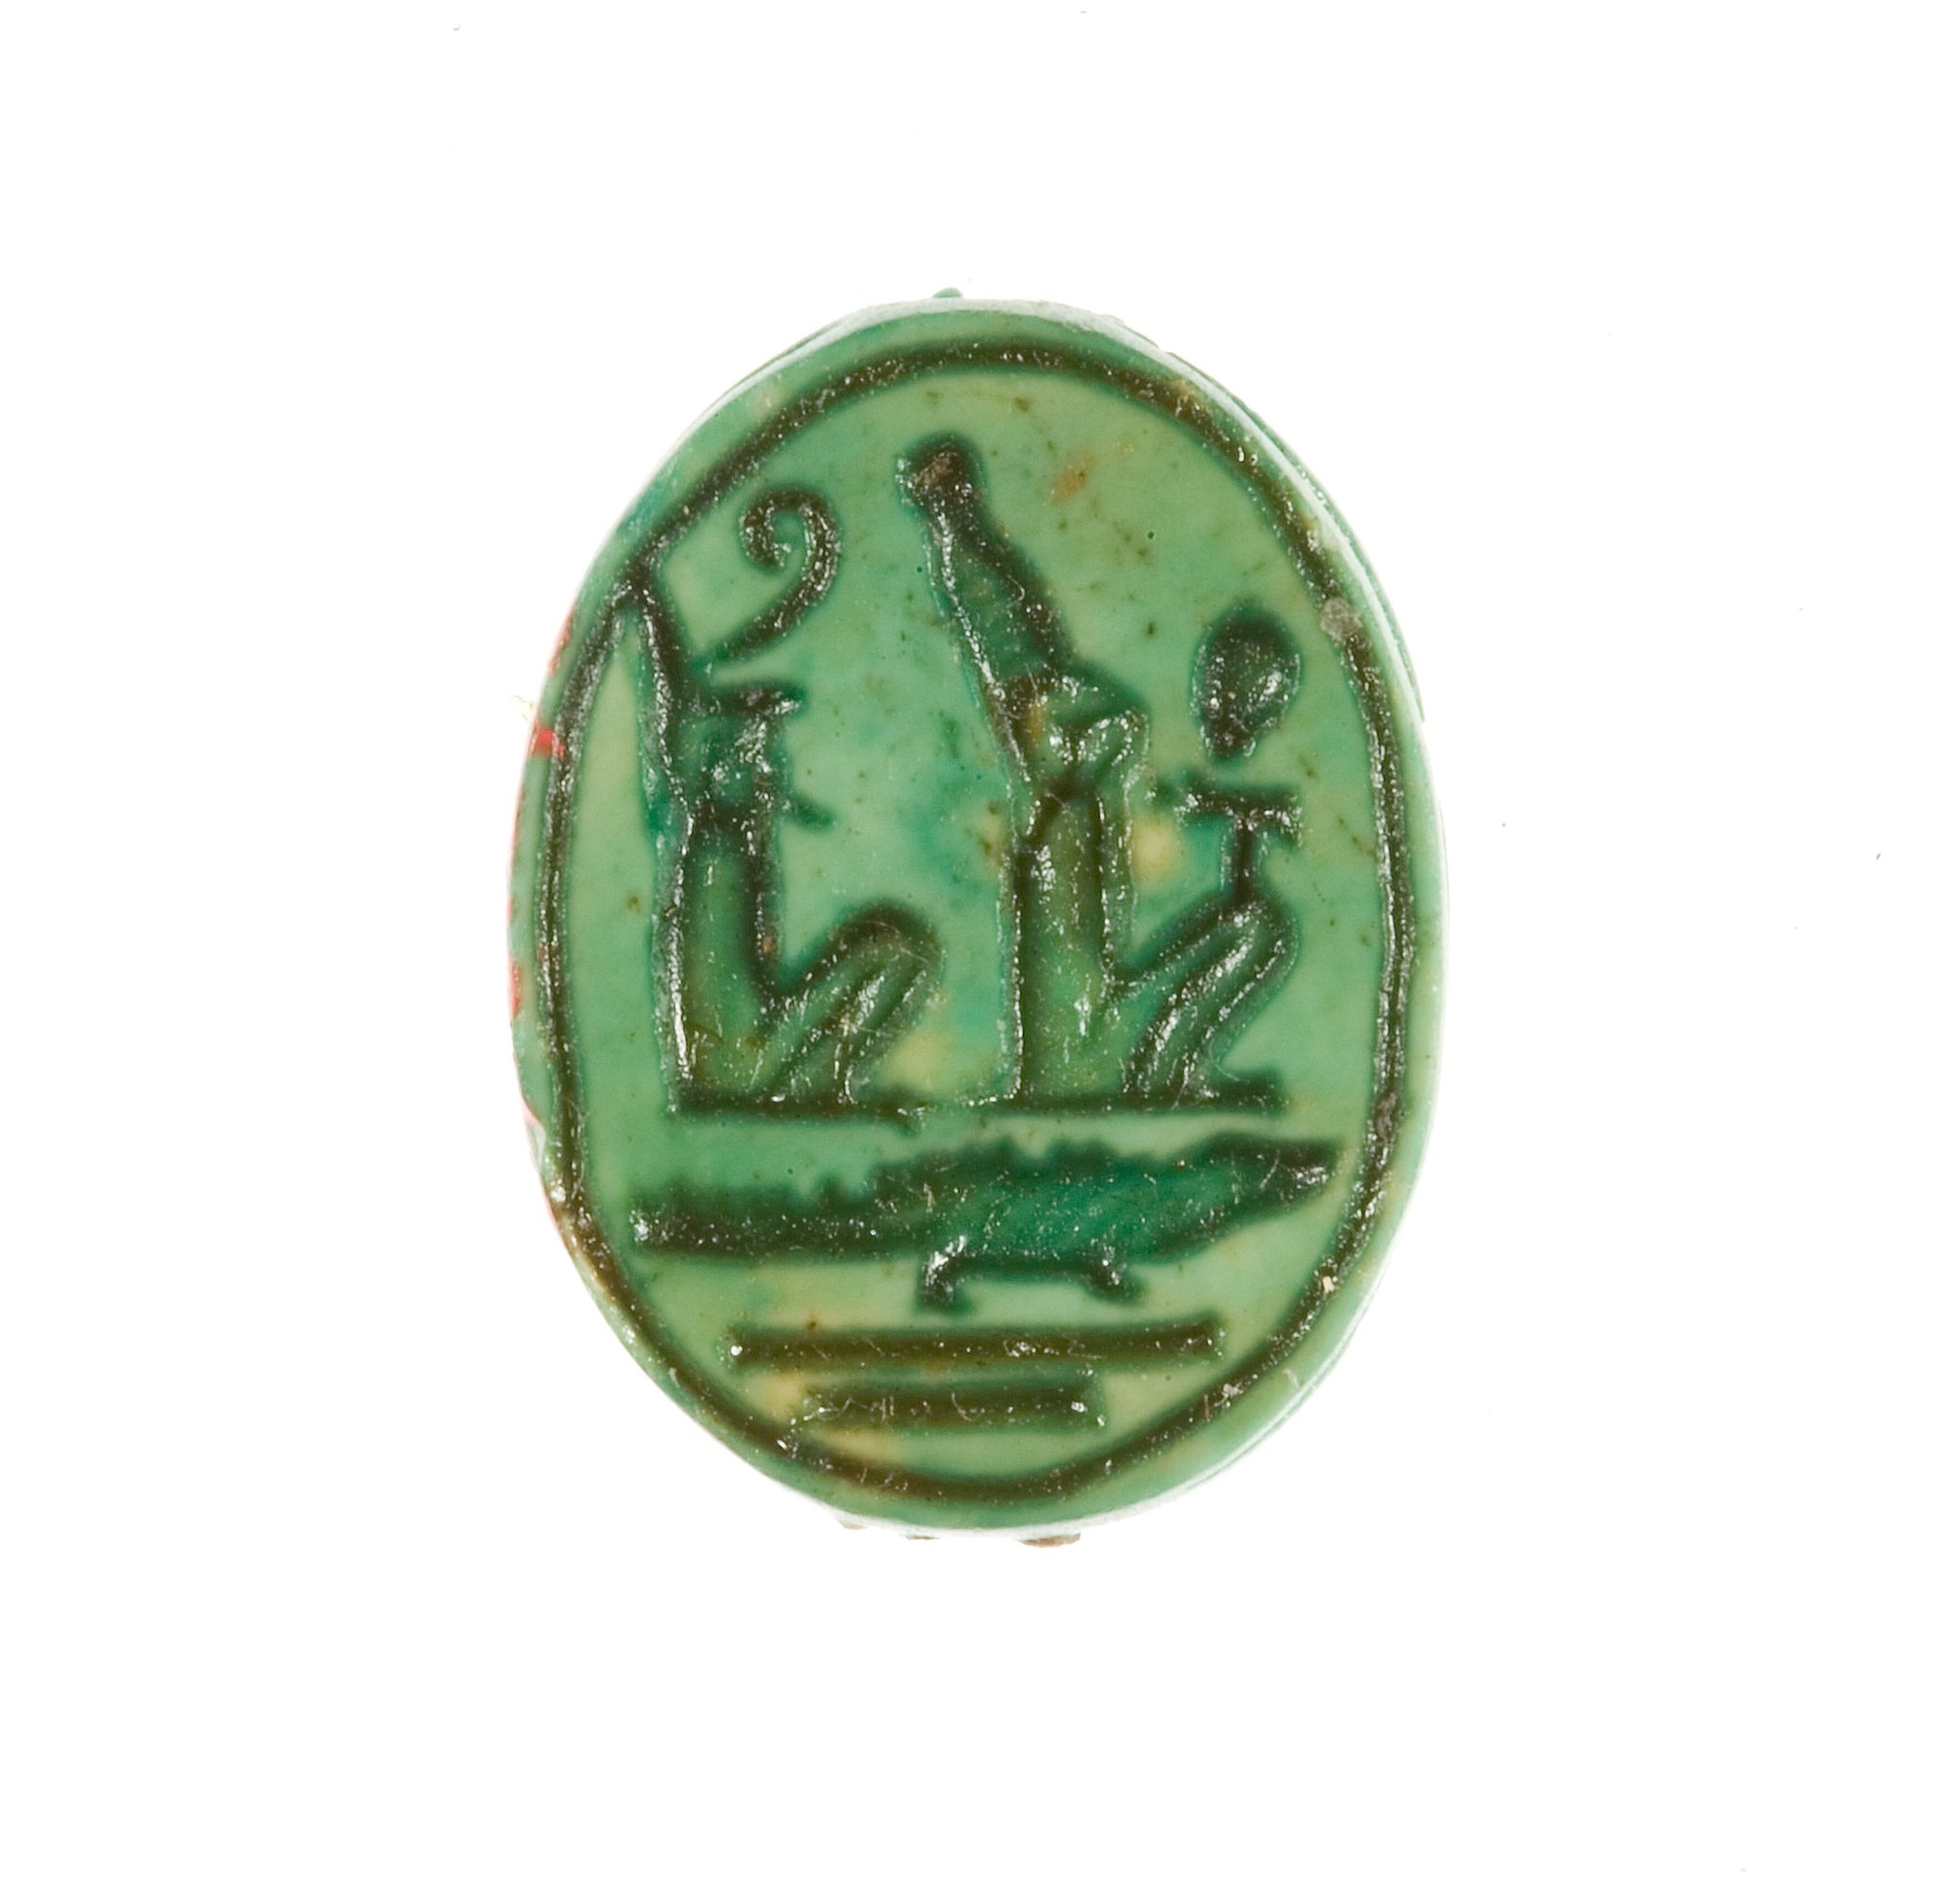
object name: scarab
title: Scarab Inscribed King of Upper and Lower Egypt, Sobek Crocodile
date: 1479-1458 BCE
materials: stone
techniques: glazing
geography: egypt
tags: kings,crocodiles,scarabs